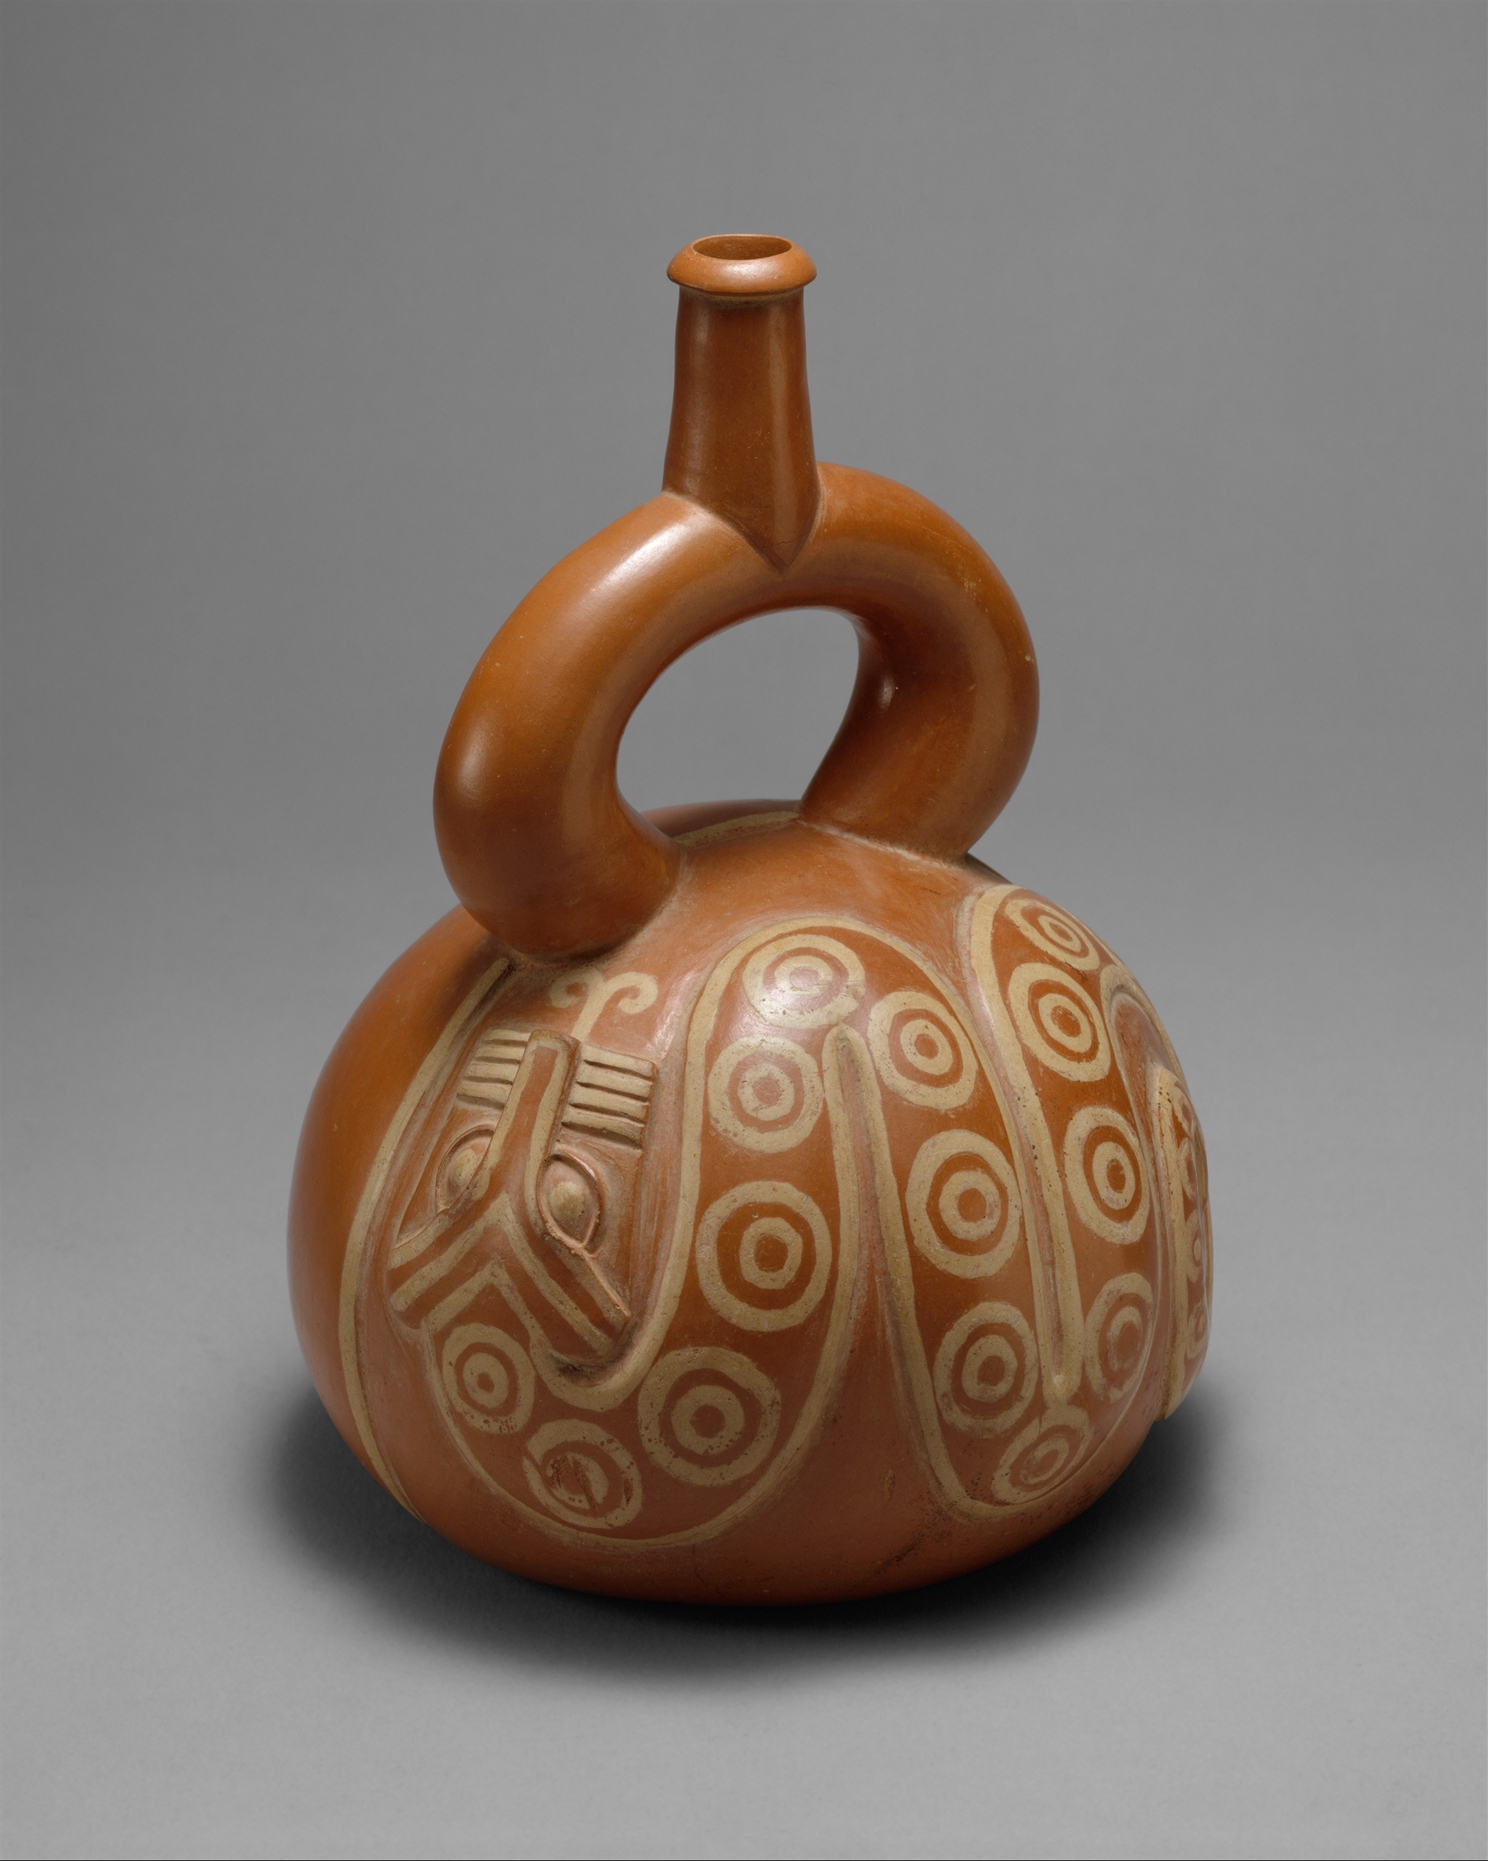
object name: bottle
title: Bottle with Snake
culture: moche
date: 101-500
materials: ceramic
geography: peru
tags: snakes